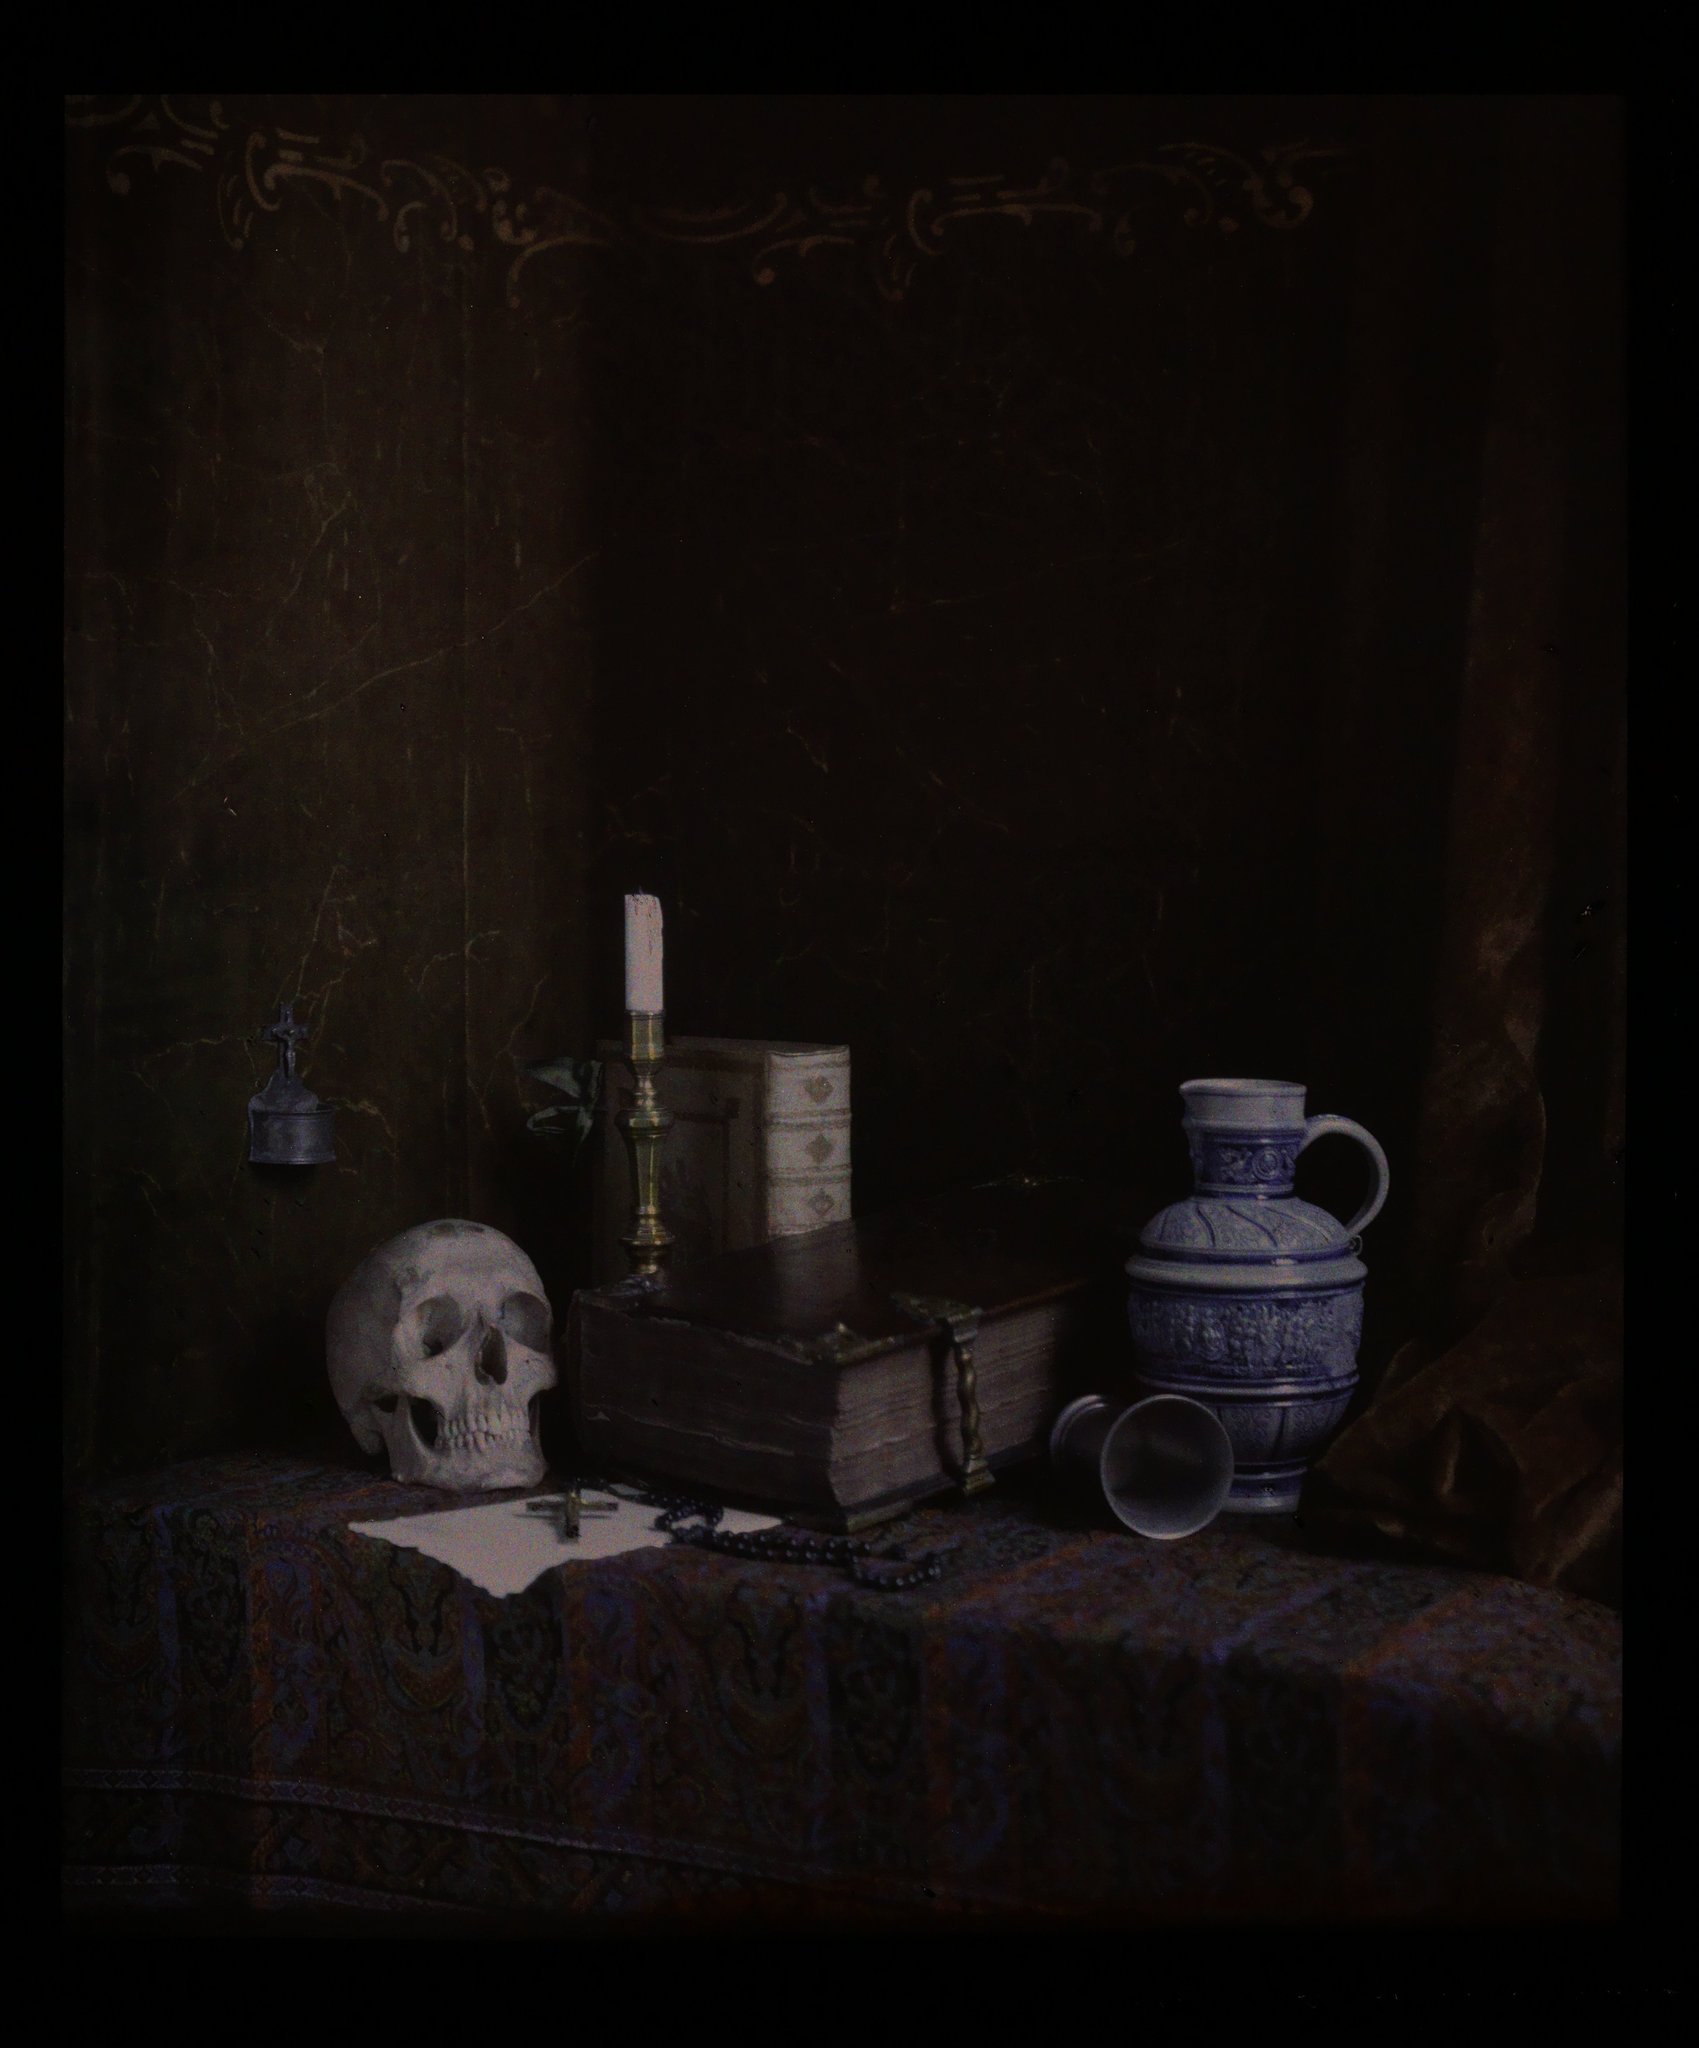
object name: photograph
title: Stilleven met een schedel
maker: Anonymous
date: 1907-1935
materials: glass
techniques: autochrome process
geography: netherlands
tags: skull as symbol of 'vanitas', still life of miscellaneous objects, netherlands